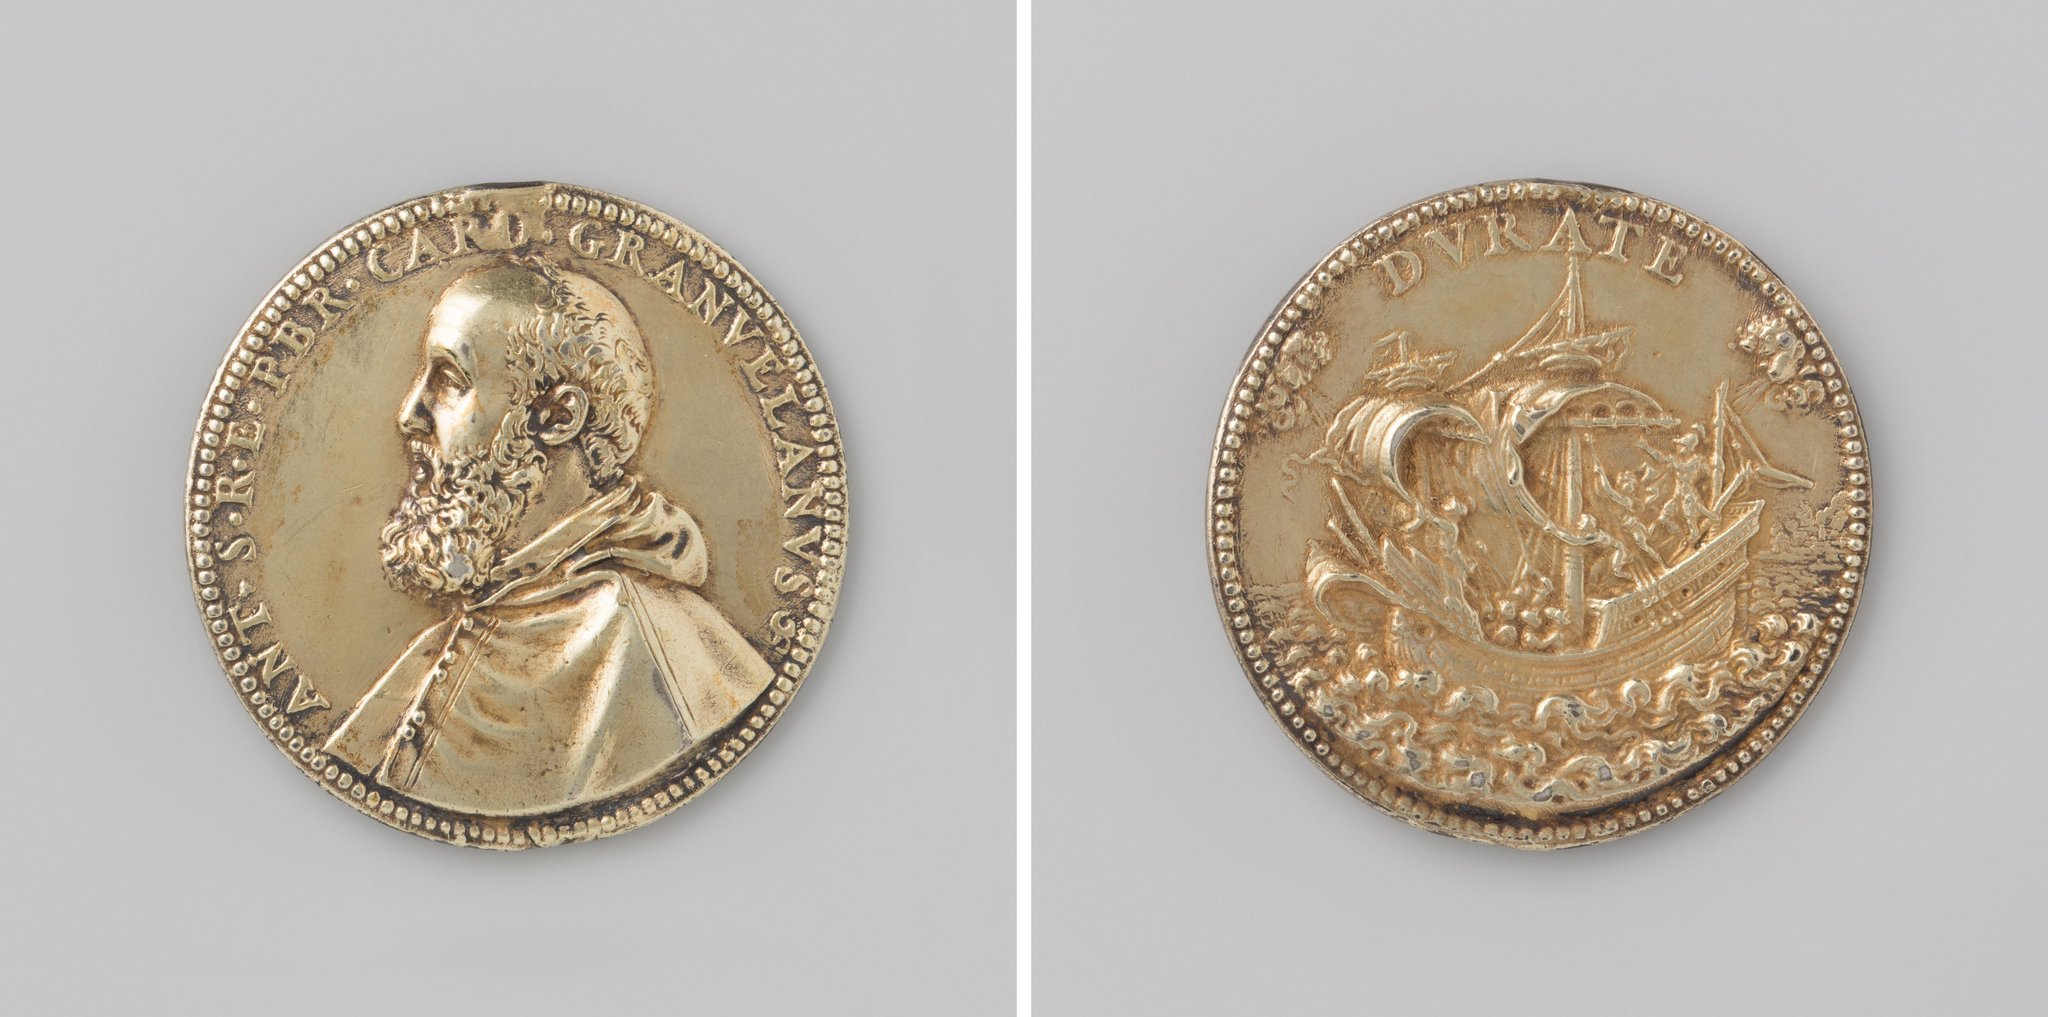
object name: history medal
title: Antoine Perrenot, kardinaal van Granvelle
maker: jacques jonghelinck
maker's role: medailleur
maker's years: 1530-1606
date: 1561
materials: silver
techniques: casting, gilding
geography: antwerp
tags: antoine perrenot de granvelle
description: Zilveren penning. Voorzijde: borststuk man binnen omschrift. Keerzijde: schip van Aeneas geteisterd door storm binnen omschrift